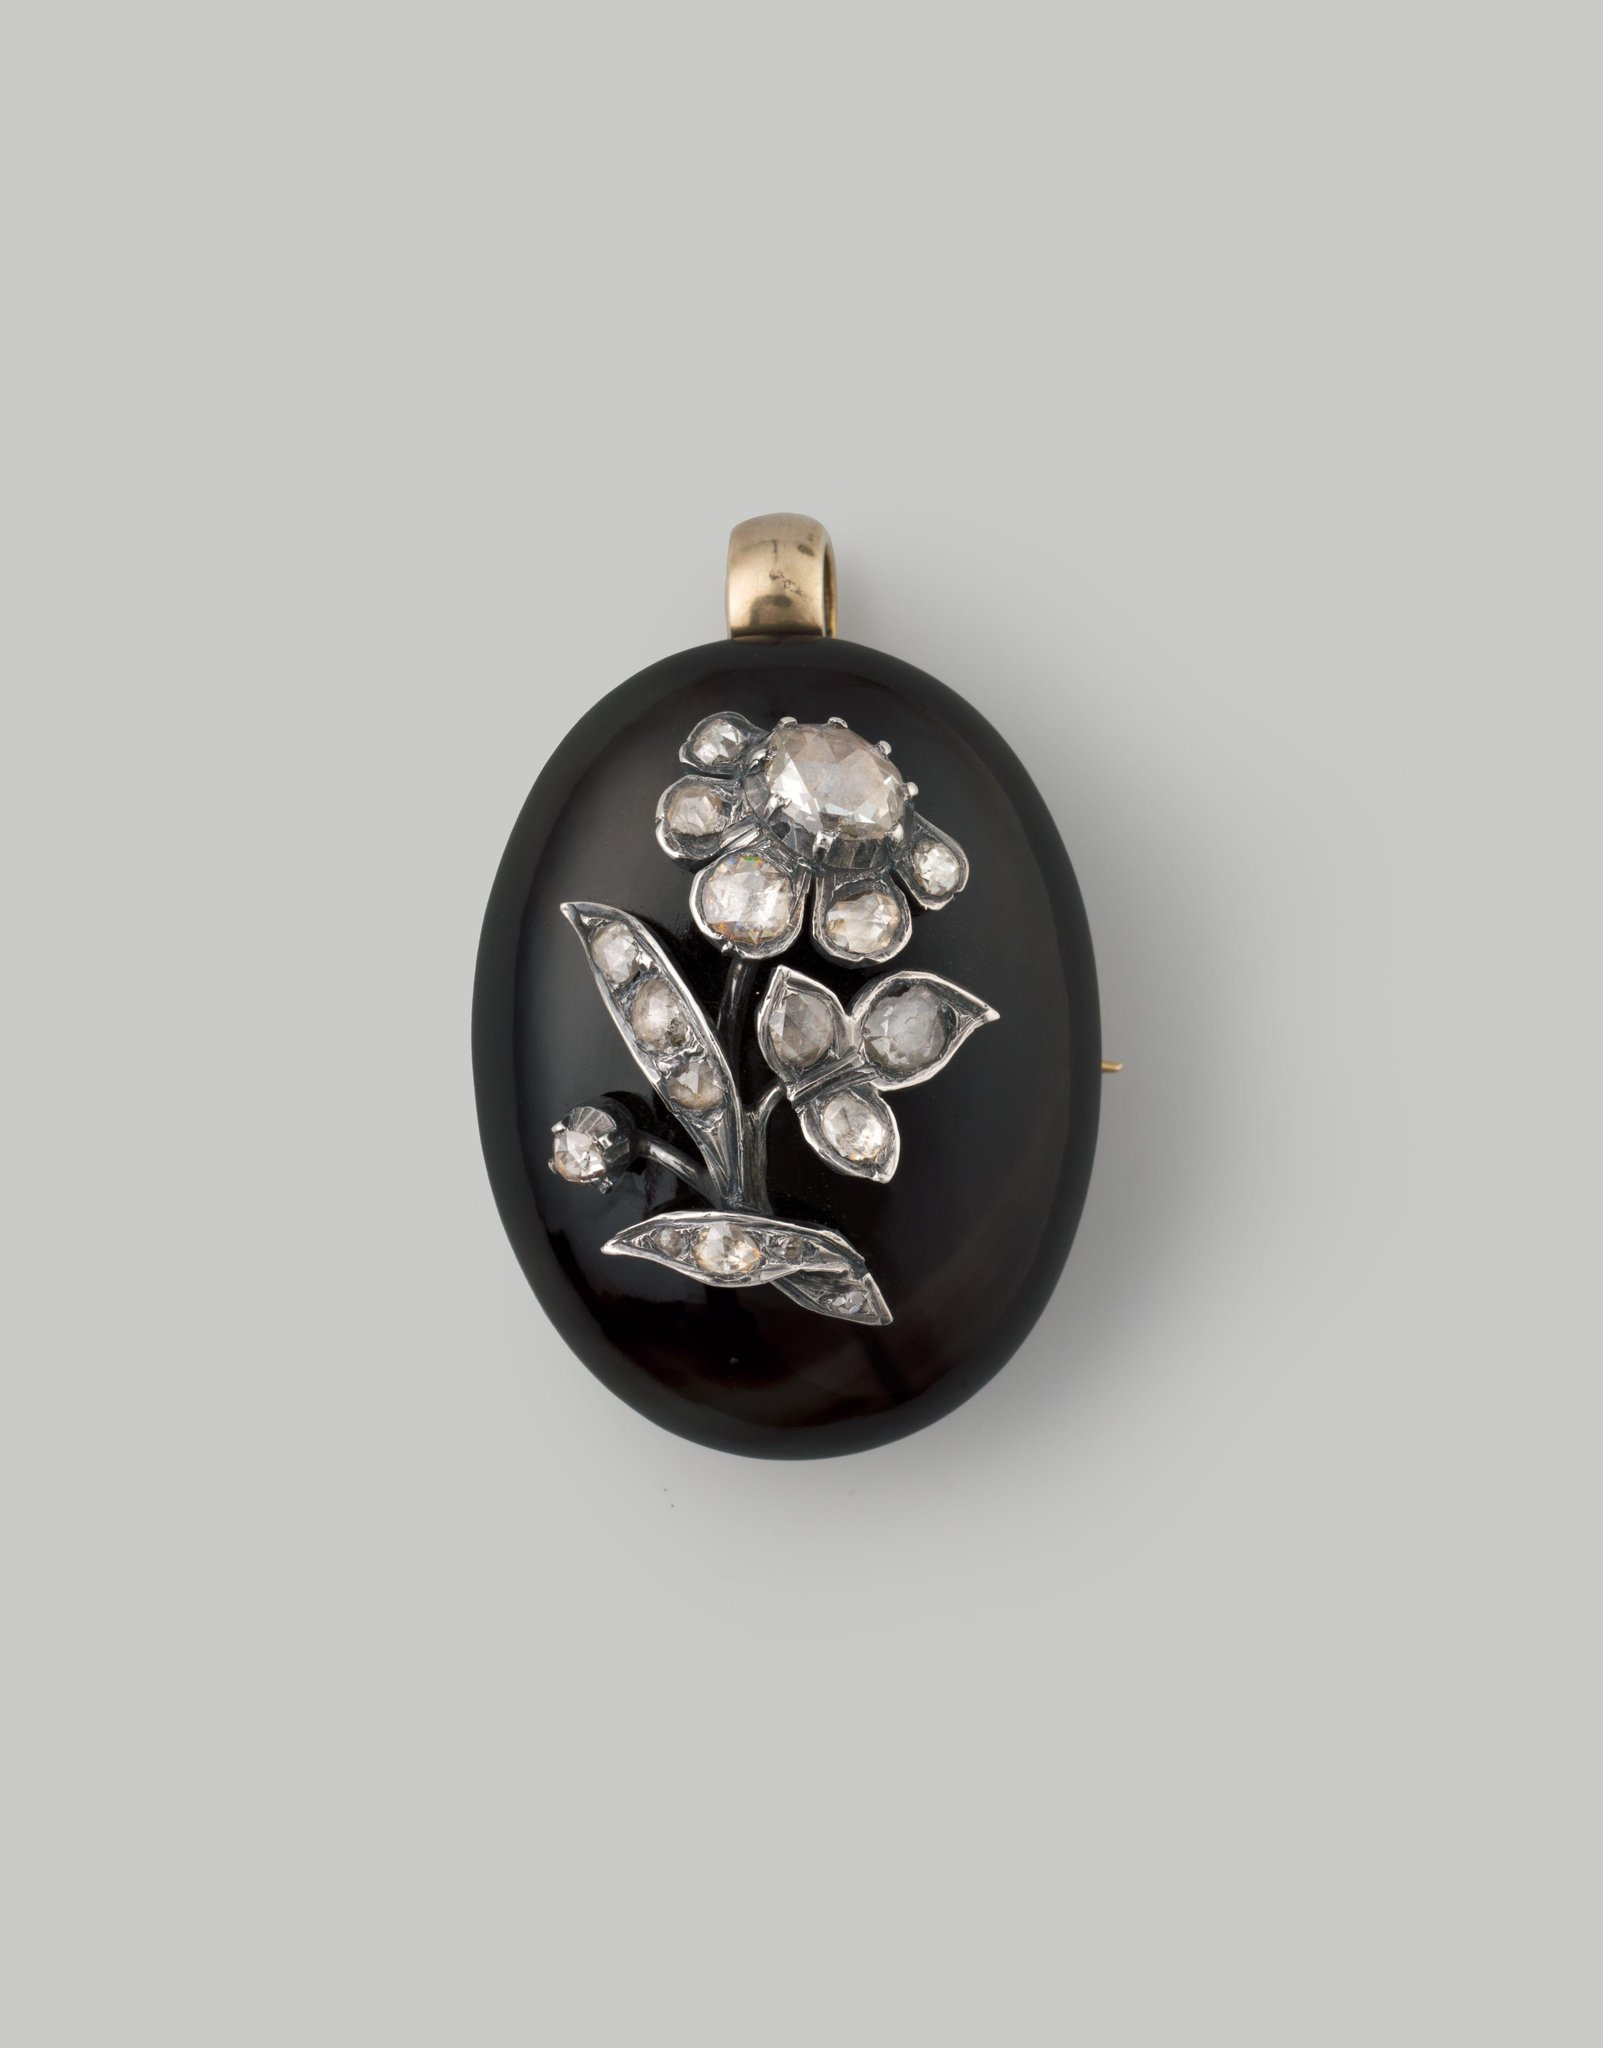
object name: brooch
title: Gouden hanger/broche, bezet met diamanten bloemapplique op onyx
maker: johan leonard van den broeke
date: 1875-1884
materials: diamond, gold, onyx, silver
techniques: grinding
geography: amsterdam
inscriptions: alloy mark: ‘(oud) eikenblad’, maker's mark, alloy mark: ‘(oud) zwaard’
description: Voorheen toegeschreven aan Gerardus Hendrikus Barends (Amsterdam) met een meesterteken, B met anker in zeshoek (M63195 in Nederlandse verantwoordelijkheidstekens vanaf 1797), dat in gebruik was tussen 1852 en 1855.